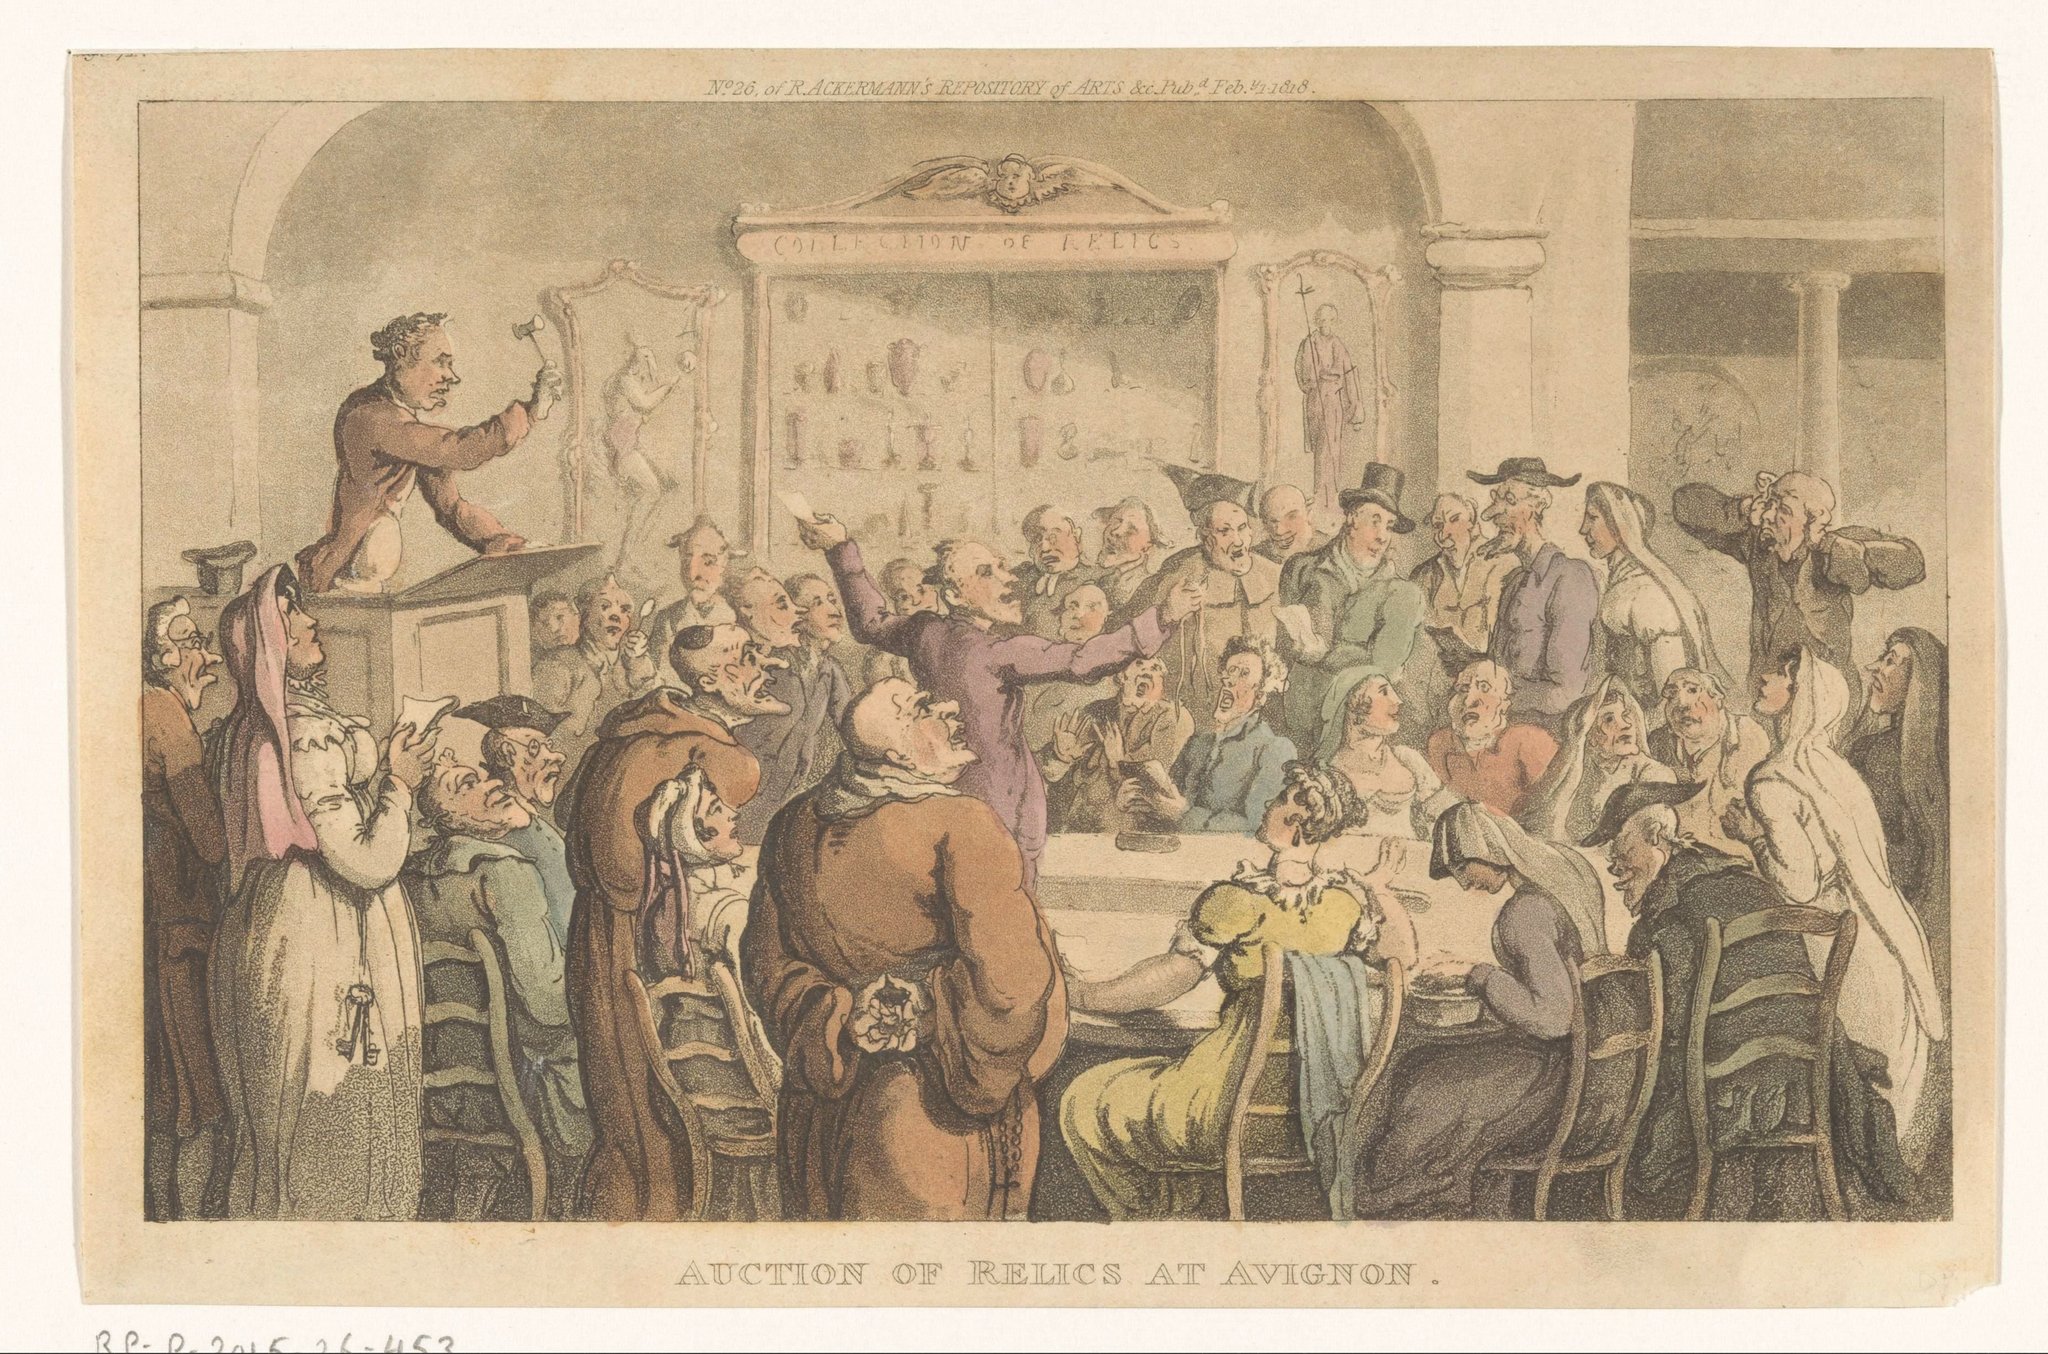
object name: print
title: Auction of Relics at Avignon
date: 1802-1818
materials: paper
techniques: aquatint, etching, hand coloring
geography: london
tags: relics (and reliquaries), art sale, auction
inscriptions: collector's mark: Lugt 4779, collector's mark: Lugt 2228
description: Interieur van een veilingzaal met links de veilingmeester op een verhoging. De kopers zitten aan een tafel in het midden of staan in de zaal, onder de aanwezigen bevinden zich ook twee geestelijken. Tegen de wand aan een kabinet met relieken. Linksboven genummerd: No. 26.